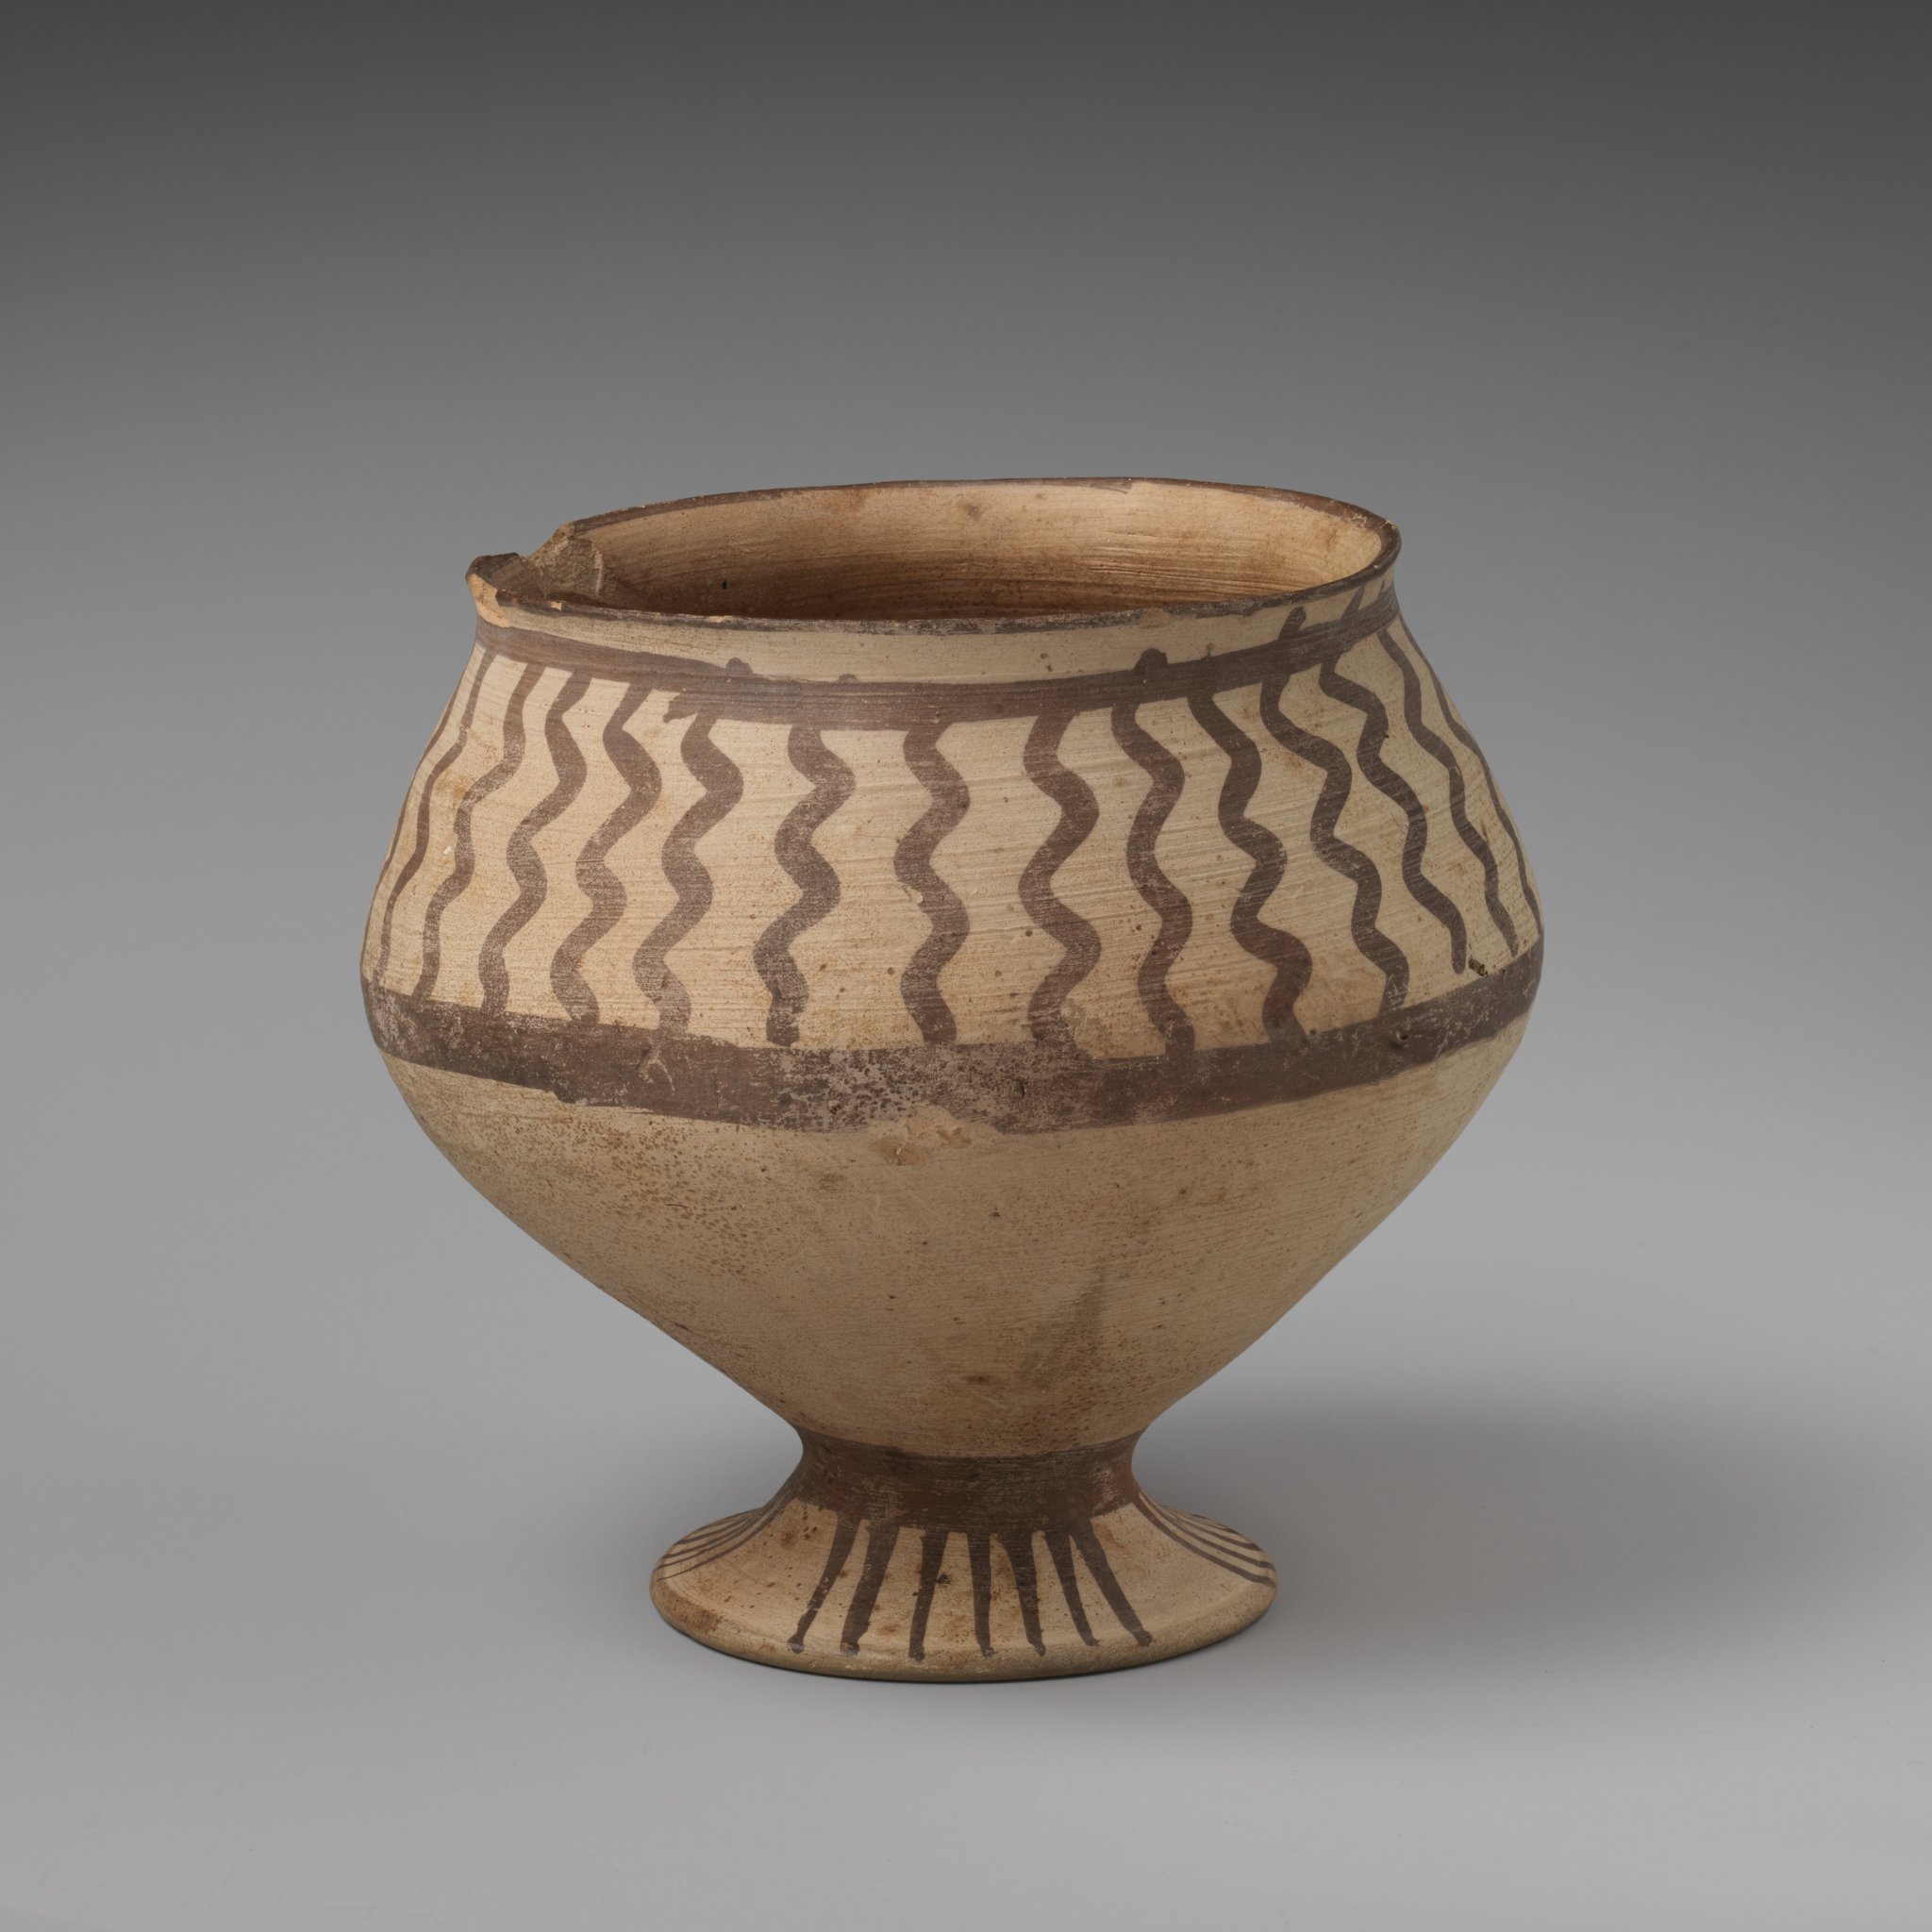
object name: cup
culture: iranian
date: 3980-3865 BCE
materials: ceramic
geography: iran